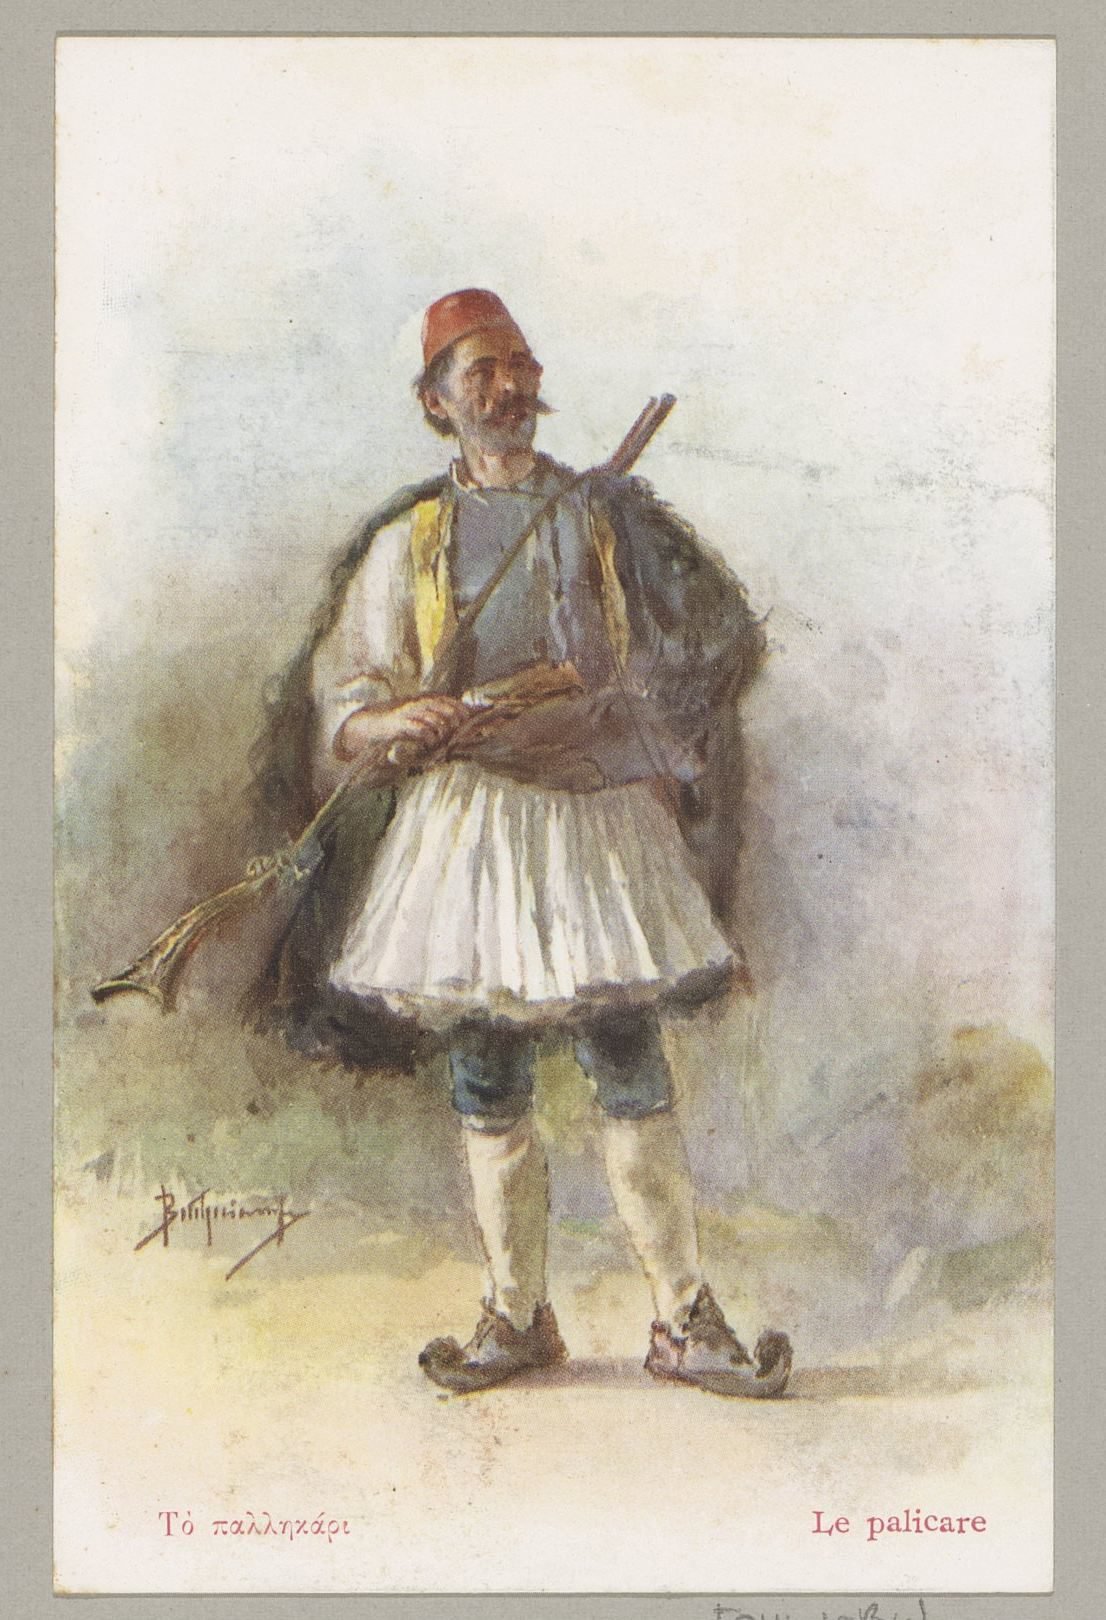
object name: ansichtkaart, prentbriefkaart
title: Le palicare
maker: Anonymous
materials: paper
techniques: color autotype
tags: land forces (+ citizen soldiery, civil guard, citizen militia)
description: Onderdeel van Fotoalbum van een reis door Zuid-Europa en het Midden-Oosten.